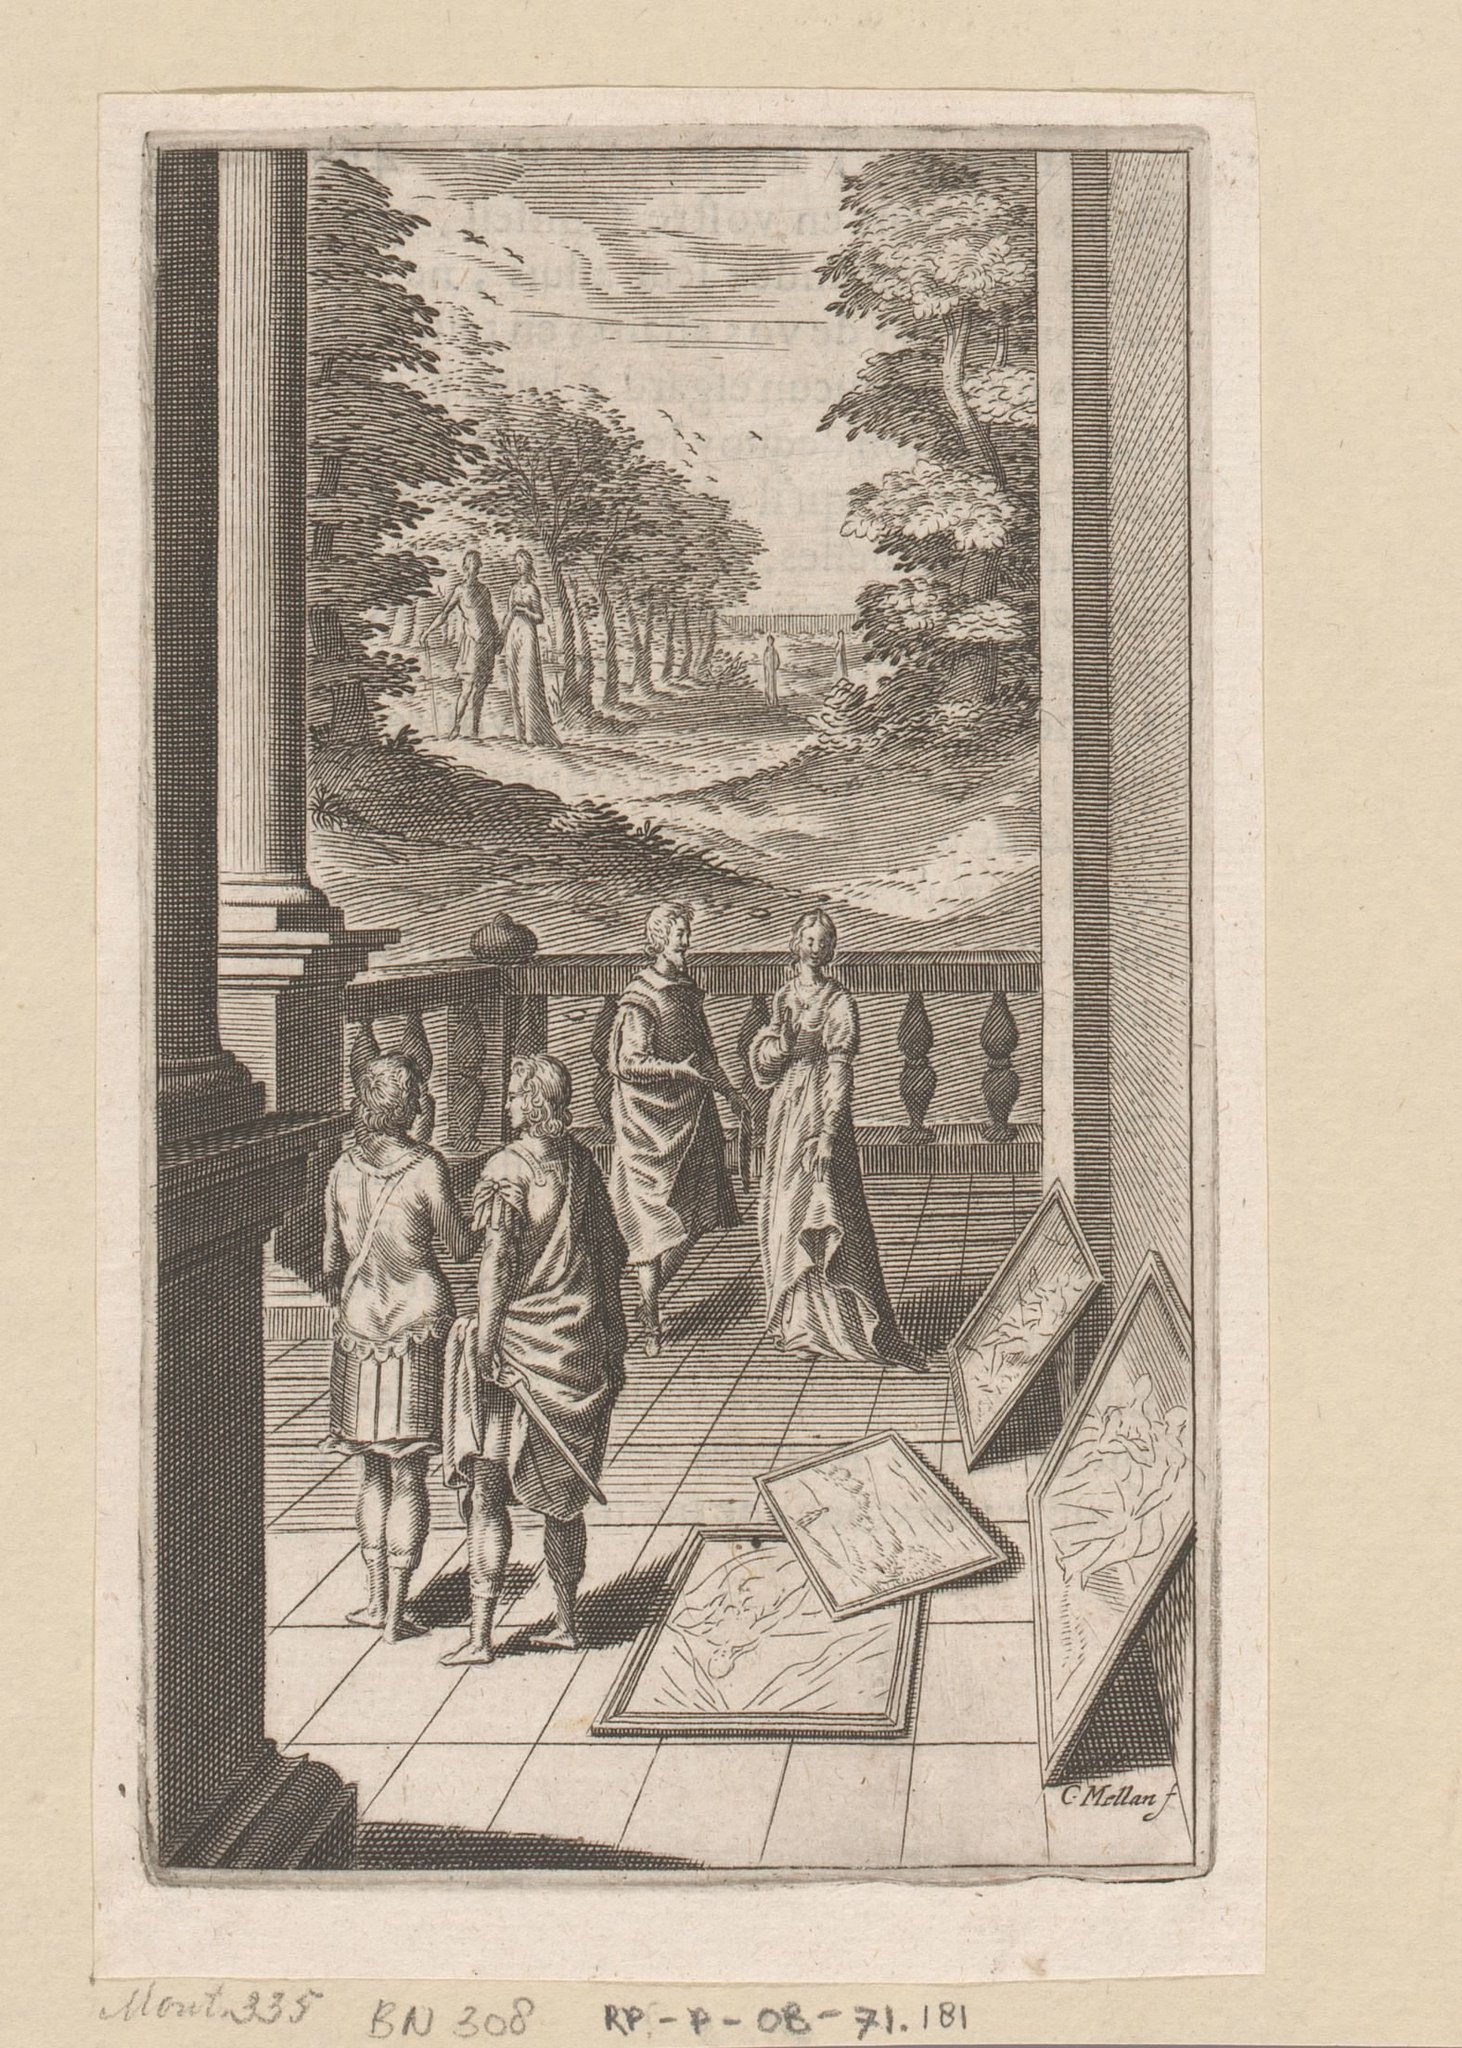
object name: book illustration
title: Radirobanes in gesprek met Argenis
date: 1624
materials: paper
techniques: engraving, letterpress printing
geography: paris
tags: terrace, picture, painting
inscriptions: collector's mark: Lugt 240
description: Prent uit: Barclay, Jean. L'Argenis. Traduction nouvelle enrichie de figures. Parijs: Nicolas Buon, 1624, dl. 3, hoofdstuk 5. In 1625 werd een tweede editie uitgegeven, eveneens door Nicolas Buon en in 1636 werd een Engelse vertaling uitgegeven door Henry Seile in Londen.